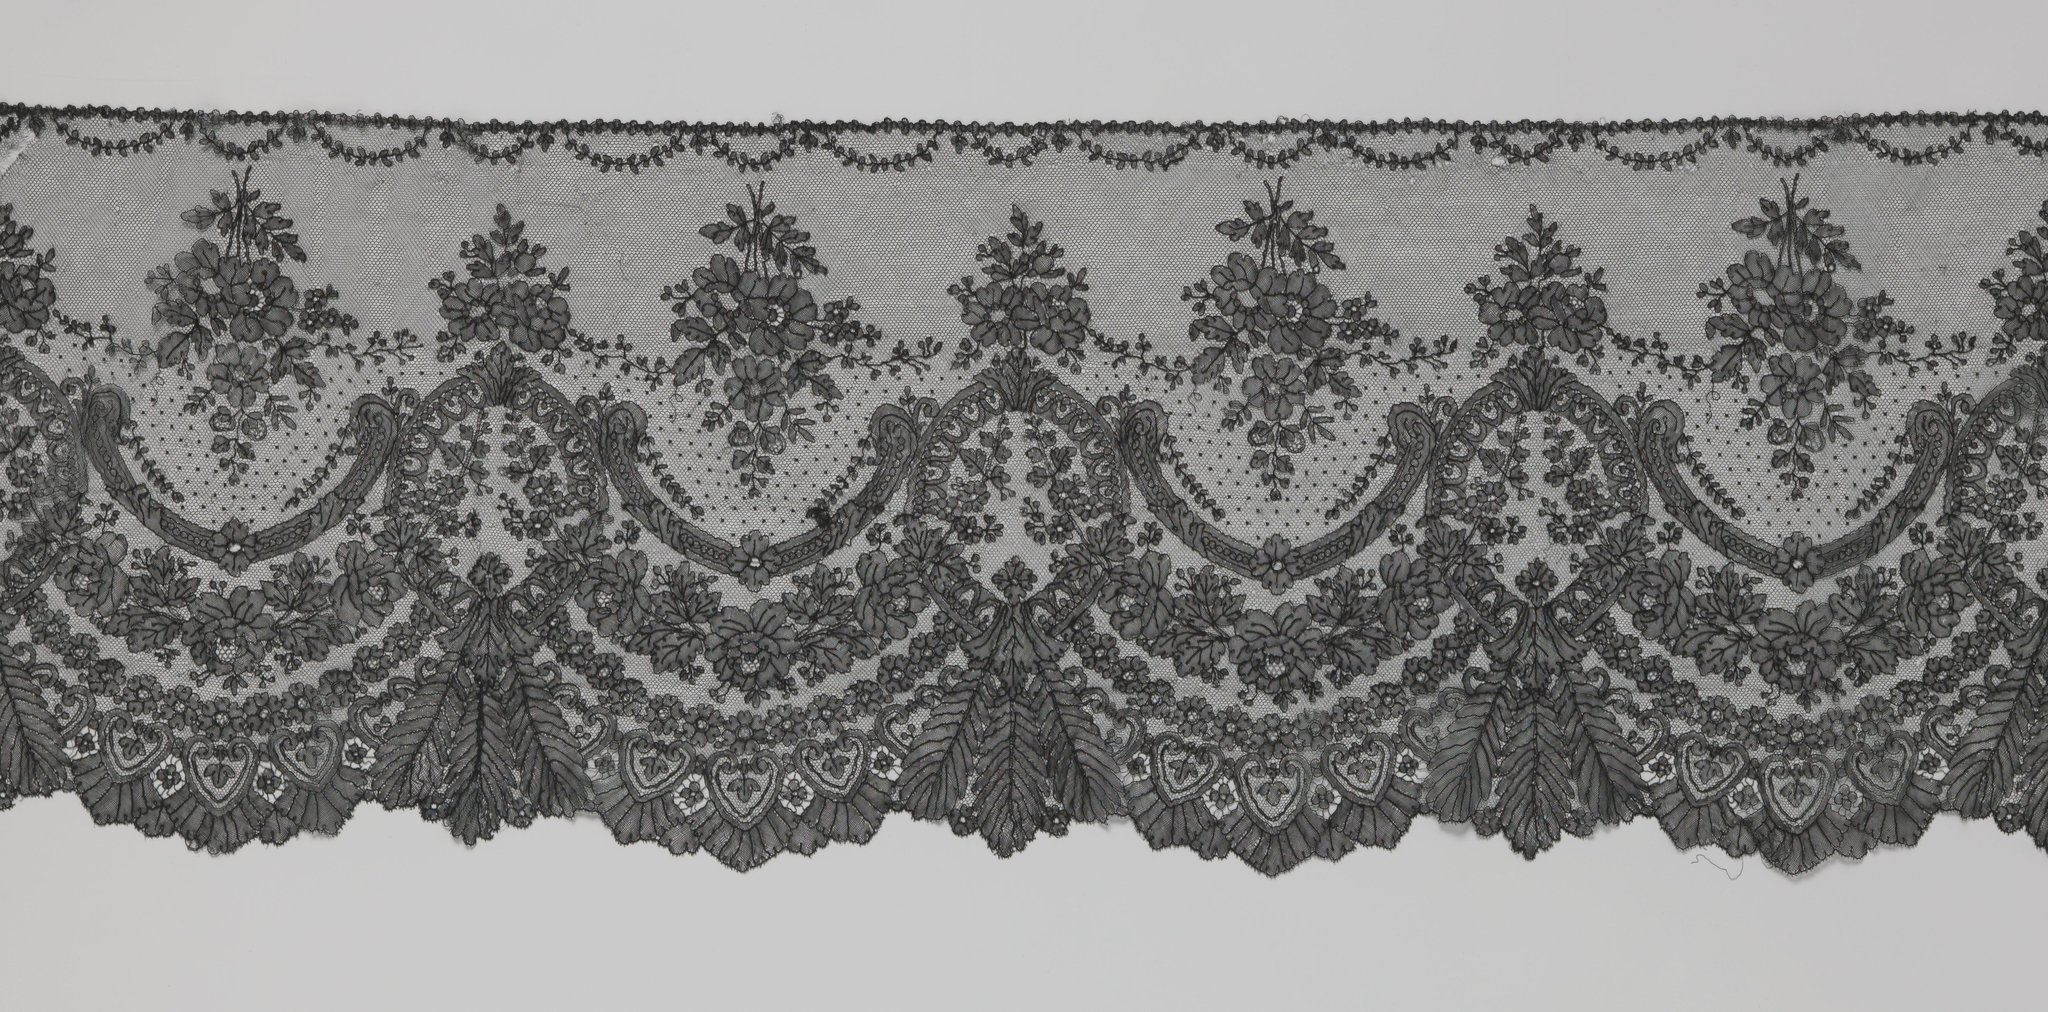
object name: strip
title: Japonstrook van zwarte kloskant met ovale cartouches en rozenslingers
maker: Anonymous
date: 1860-1880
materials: silk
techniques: lace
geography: france